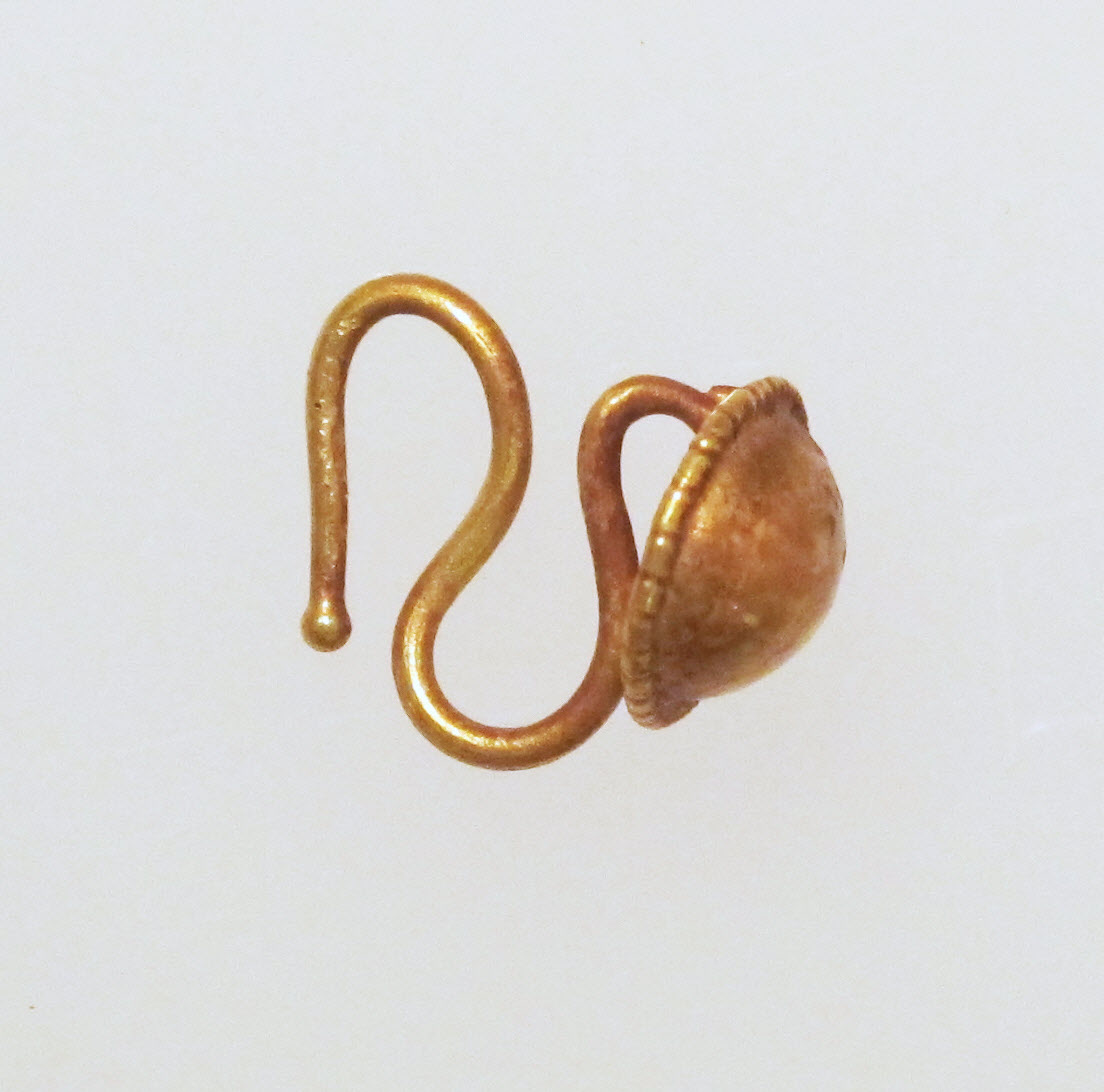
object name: earring hook type with disc and beaded rim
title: Earring-hook type with disc and beaded rim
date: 7000 BCE-330 CE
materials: gold